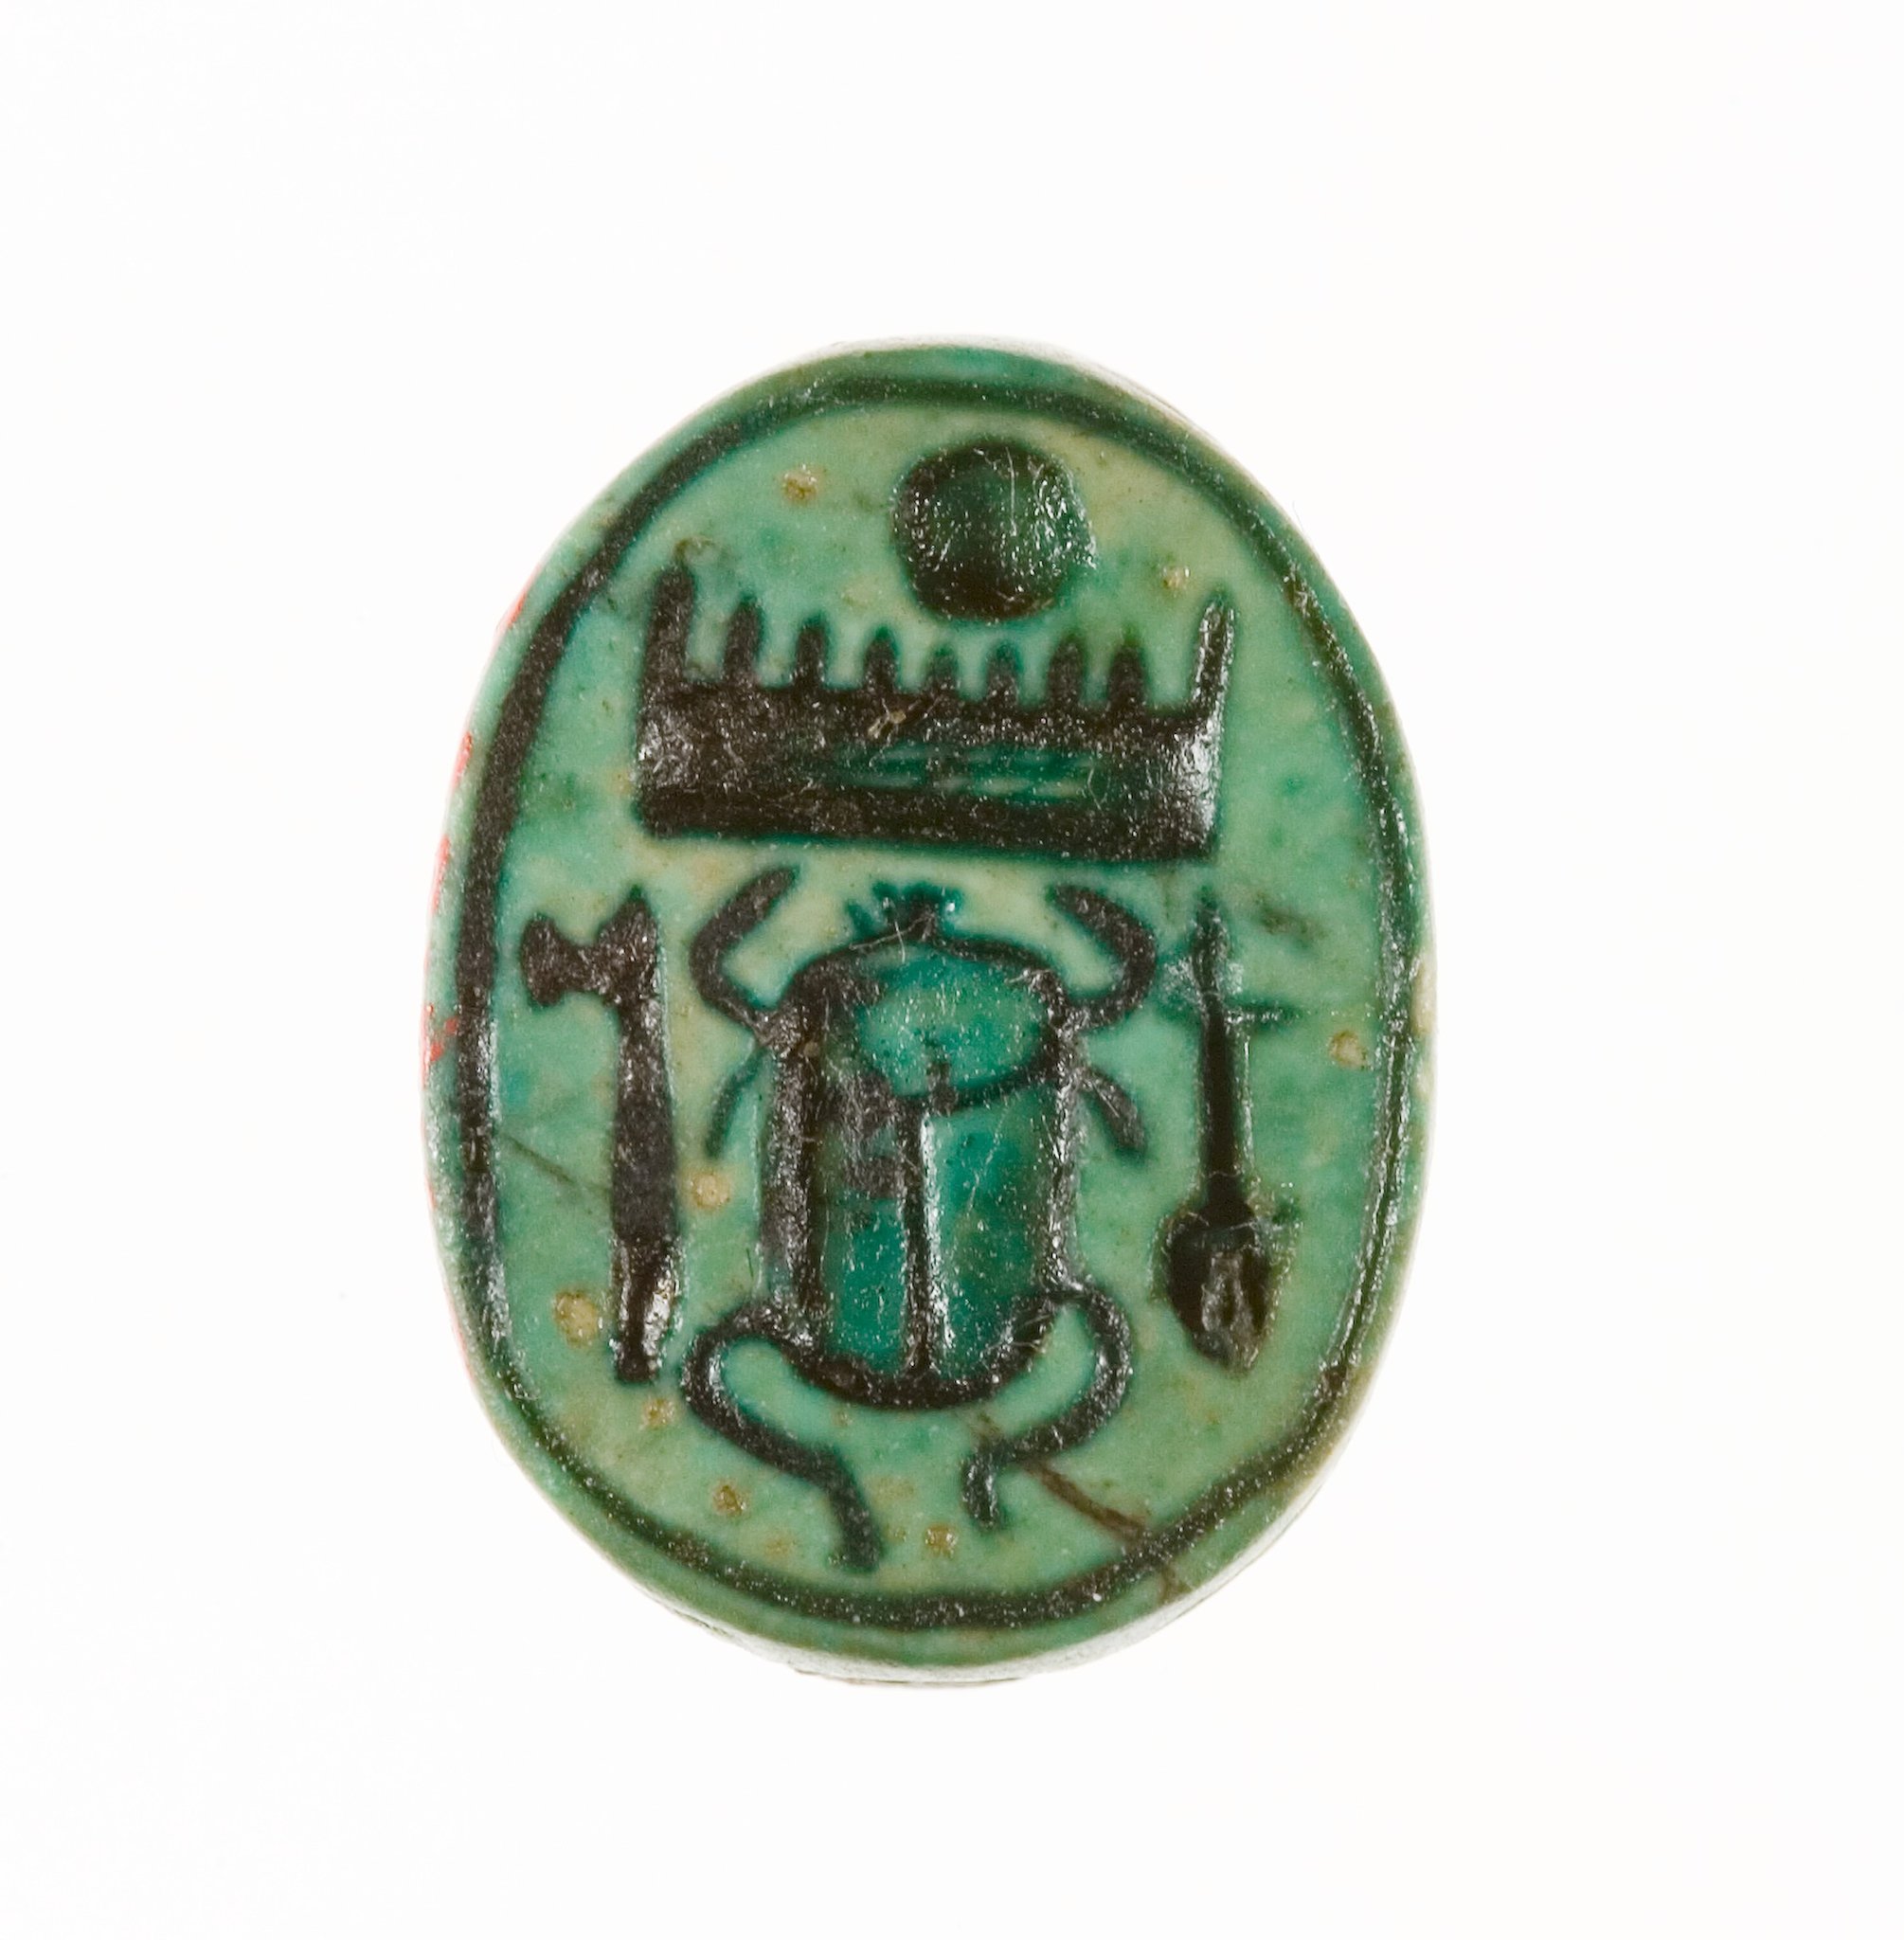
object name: scarab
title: Scarab Inscribed with the Throne Name of Thutmose III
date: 1479-1458 BCE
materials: stone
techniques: glazing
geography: egypt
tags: hieroglyphs,scarabs